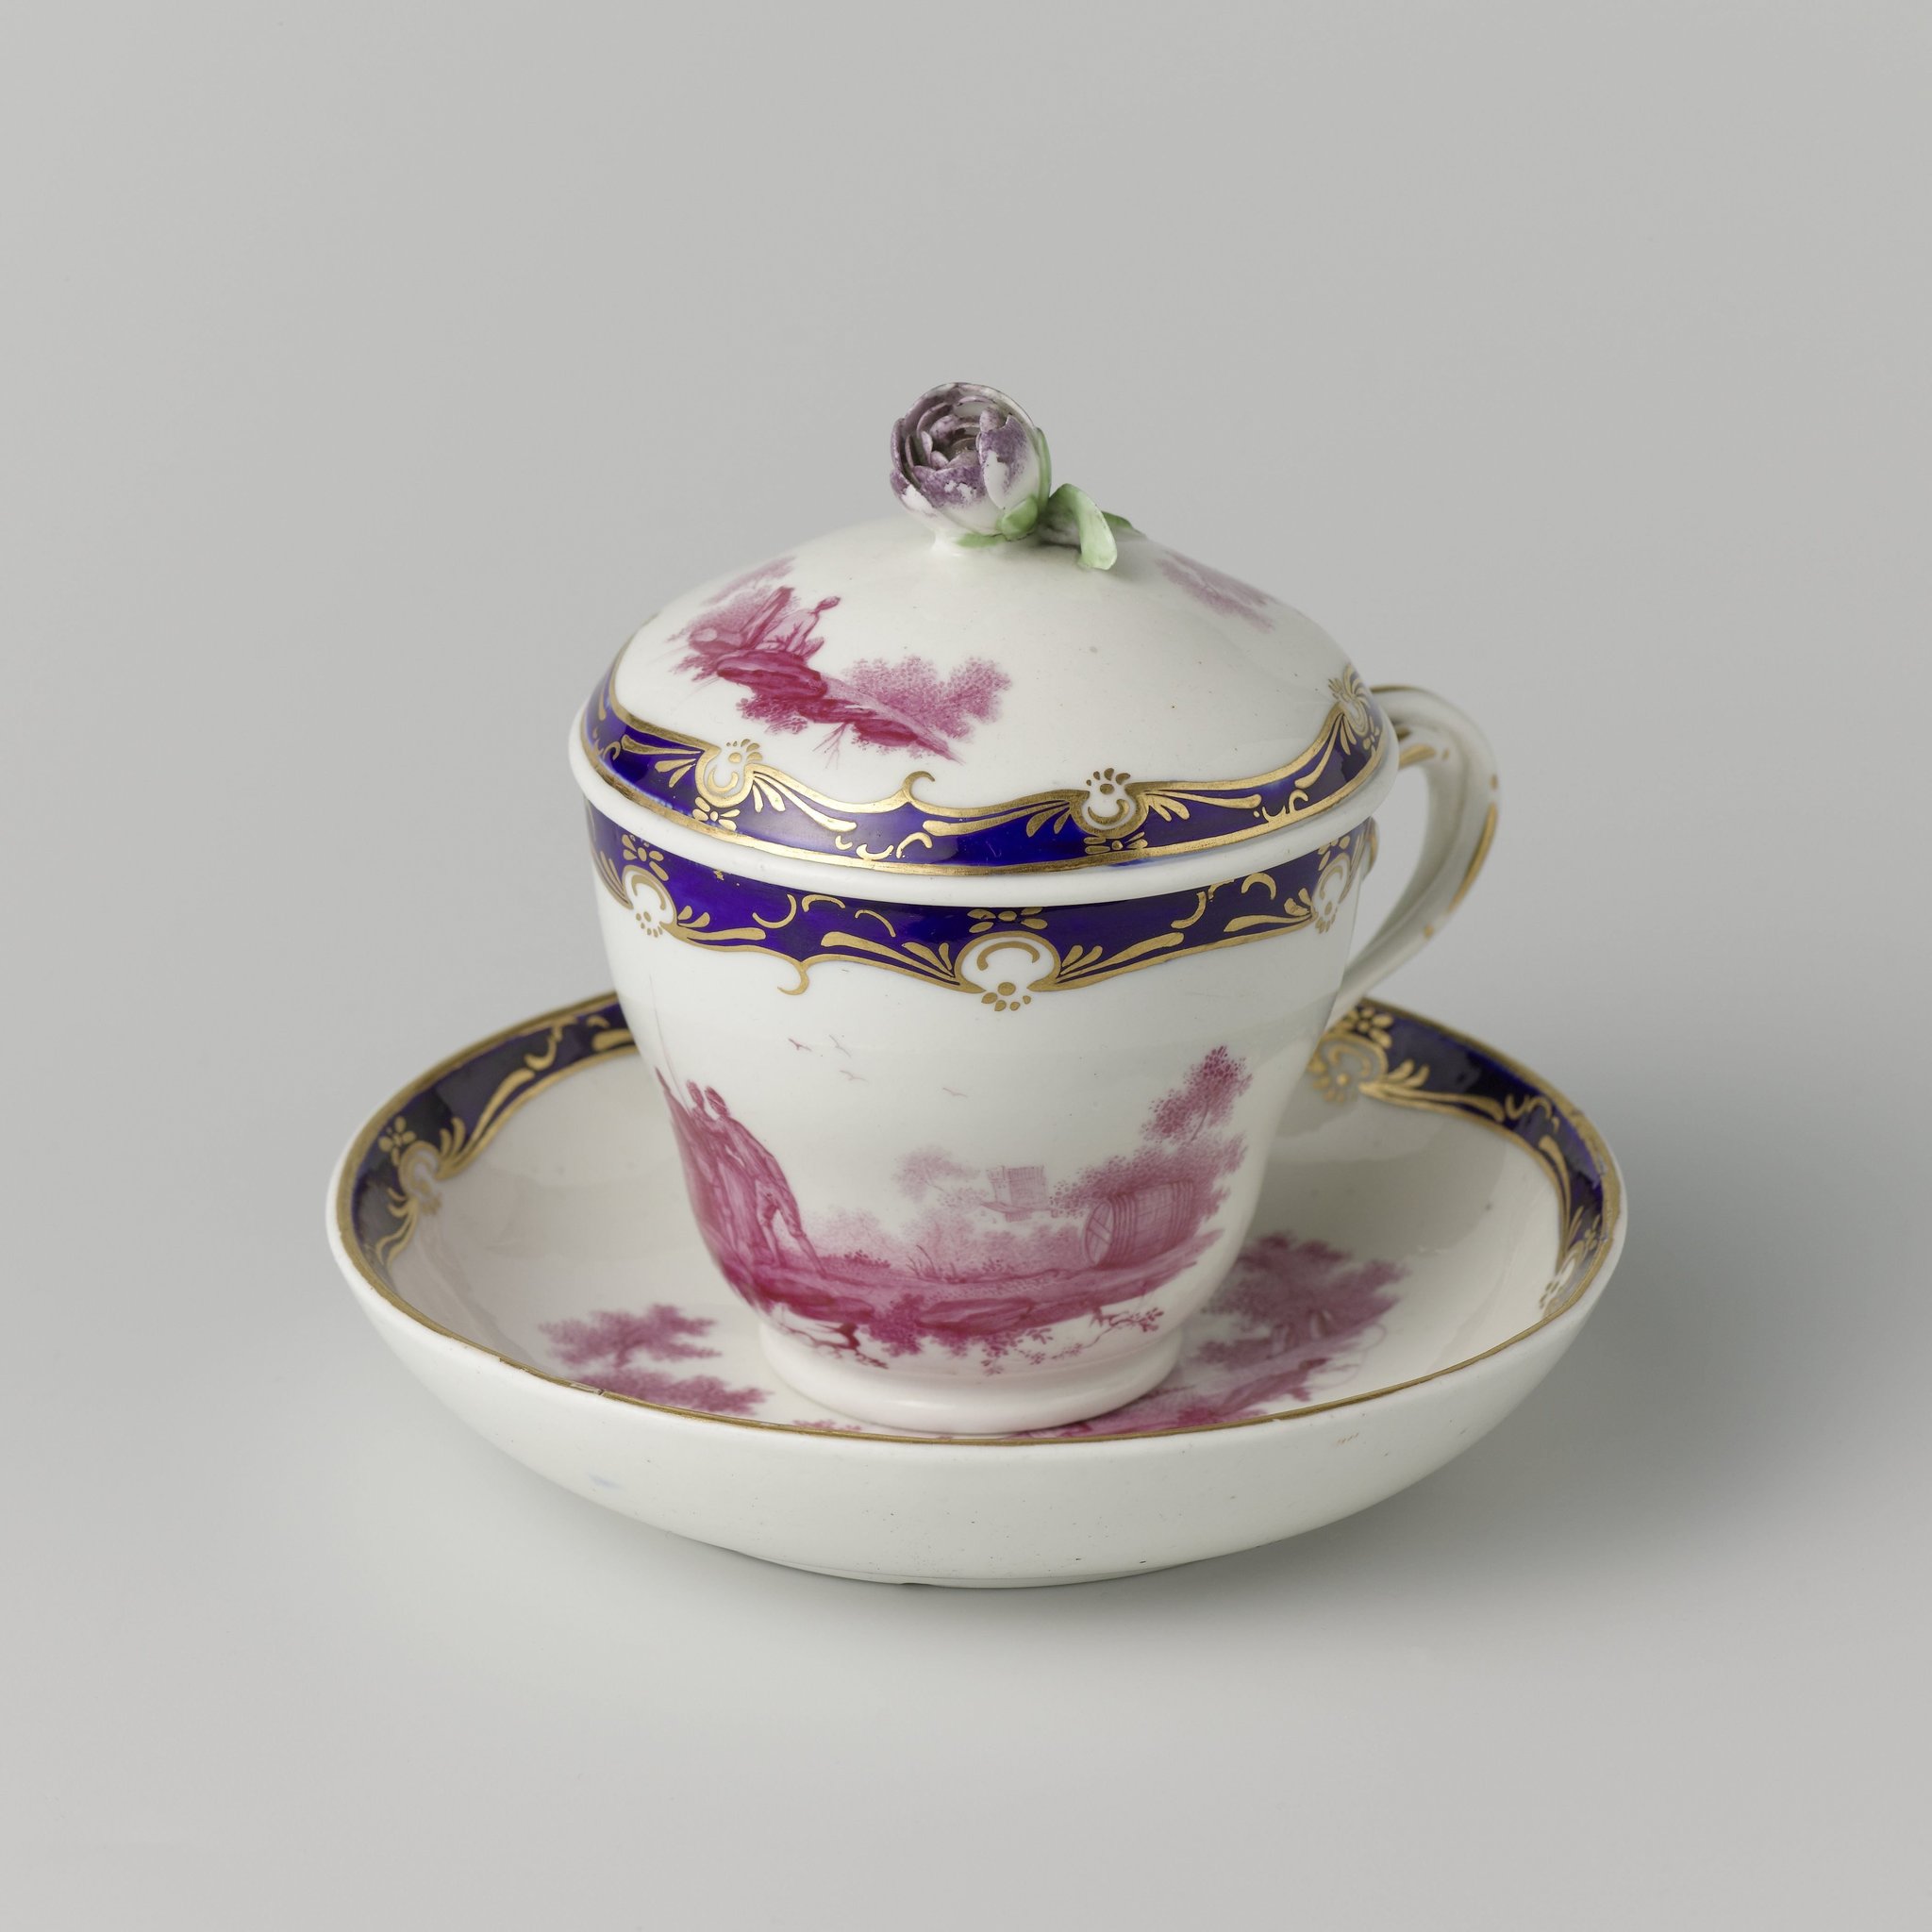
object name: chocolate cup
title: Lidded chocolate cup and saucer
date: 1777-1790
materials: porcelain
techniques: painted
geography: doornik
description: Tournai painted decoration: Porseleinfabriek Den Haag, c. 1777–1790 soft-paste porcelain (pâte-tendre)